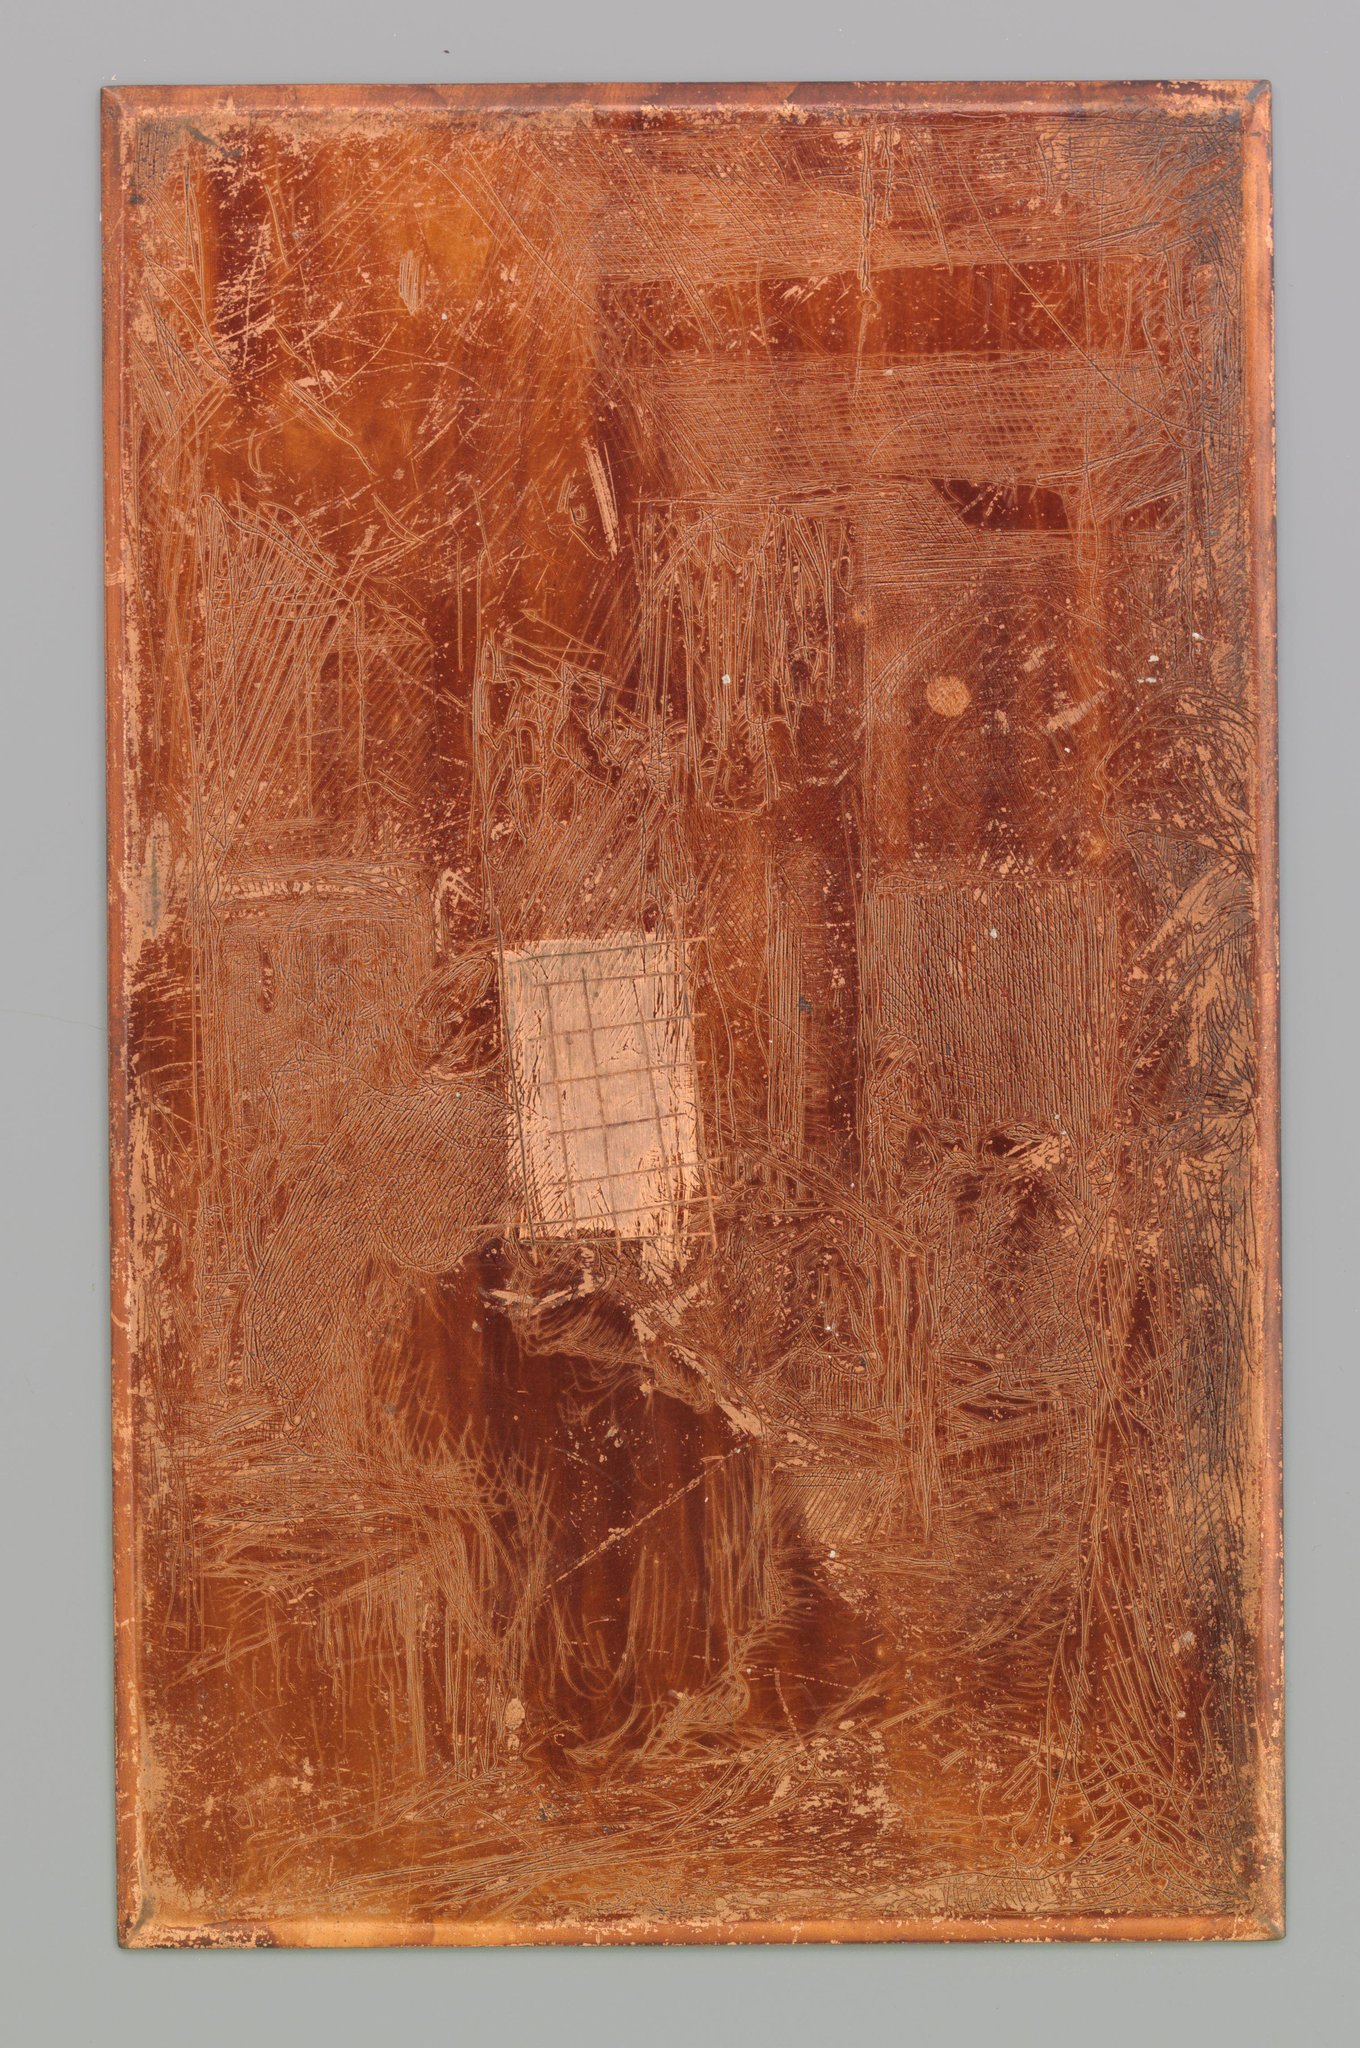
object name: copper plate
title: Schoenenbazaar te Caïro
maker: marius bauer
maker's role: draughtsman, print maker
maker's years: 1867-1932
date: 1924-1932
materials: copper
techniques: etching